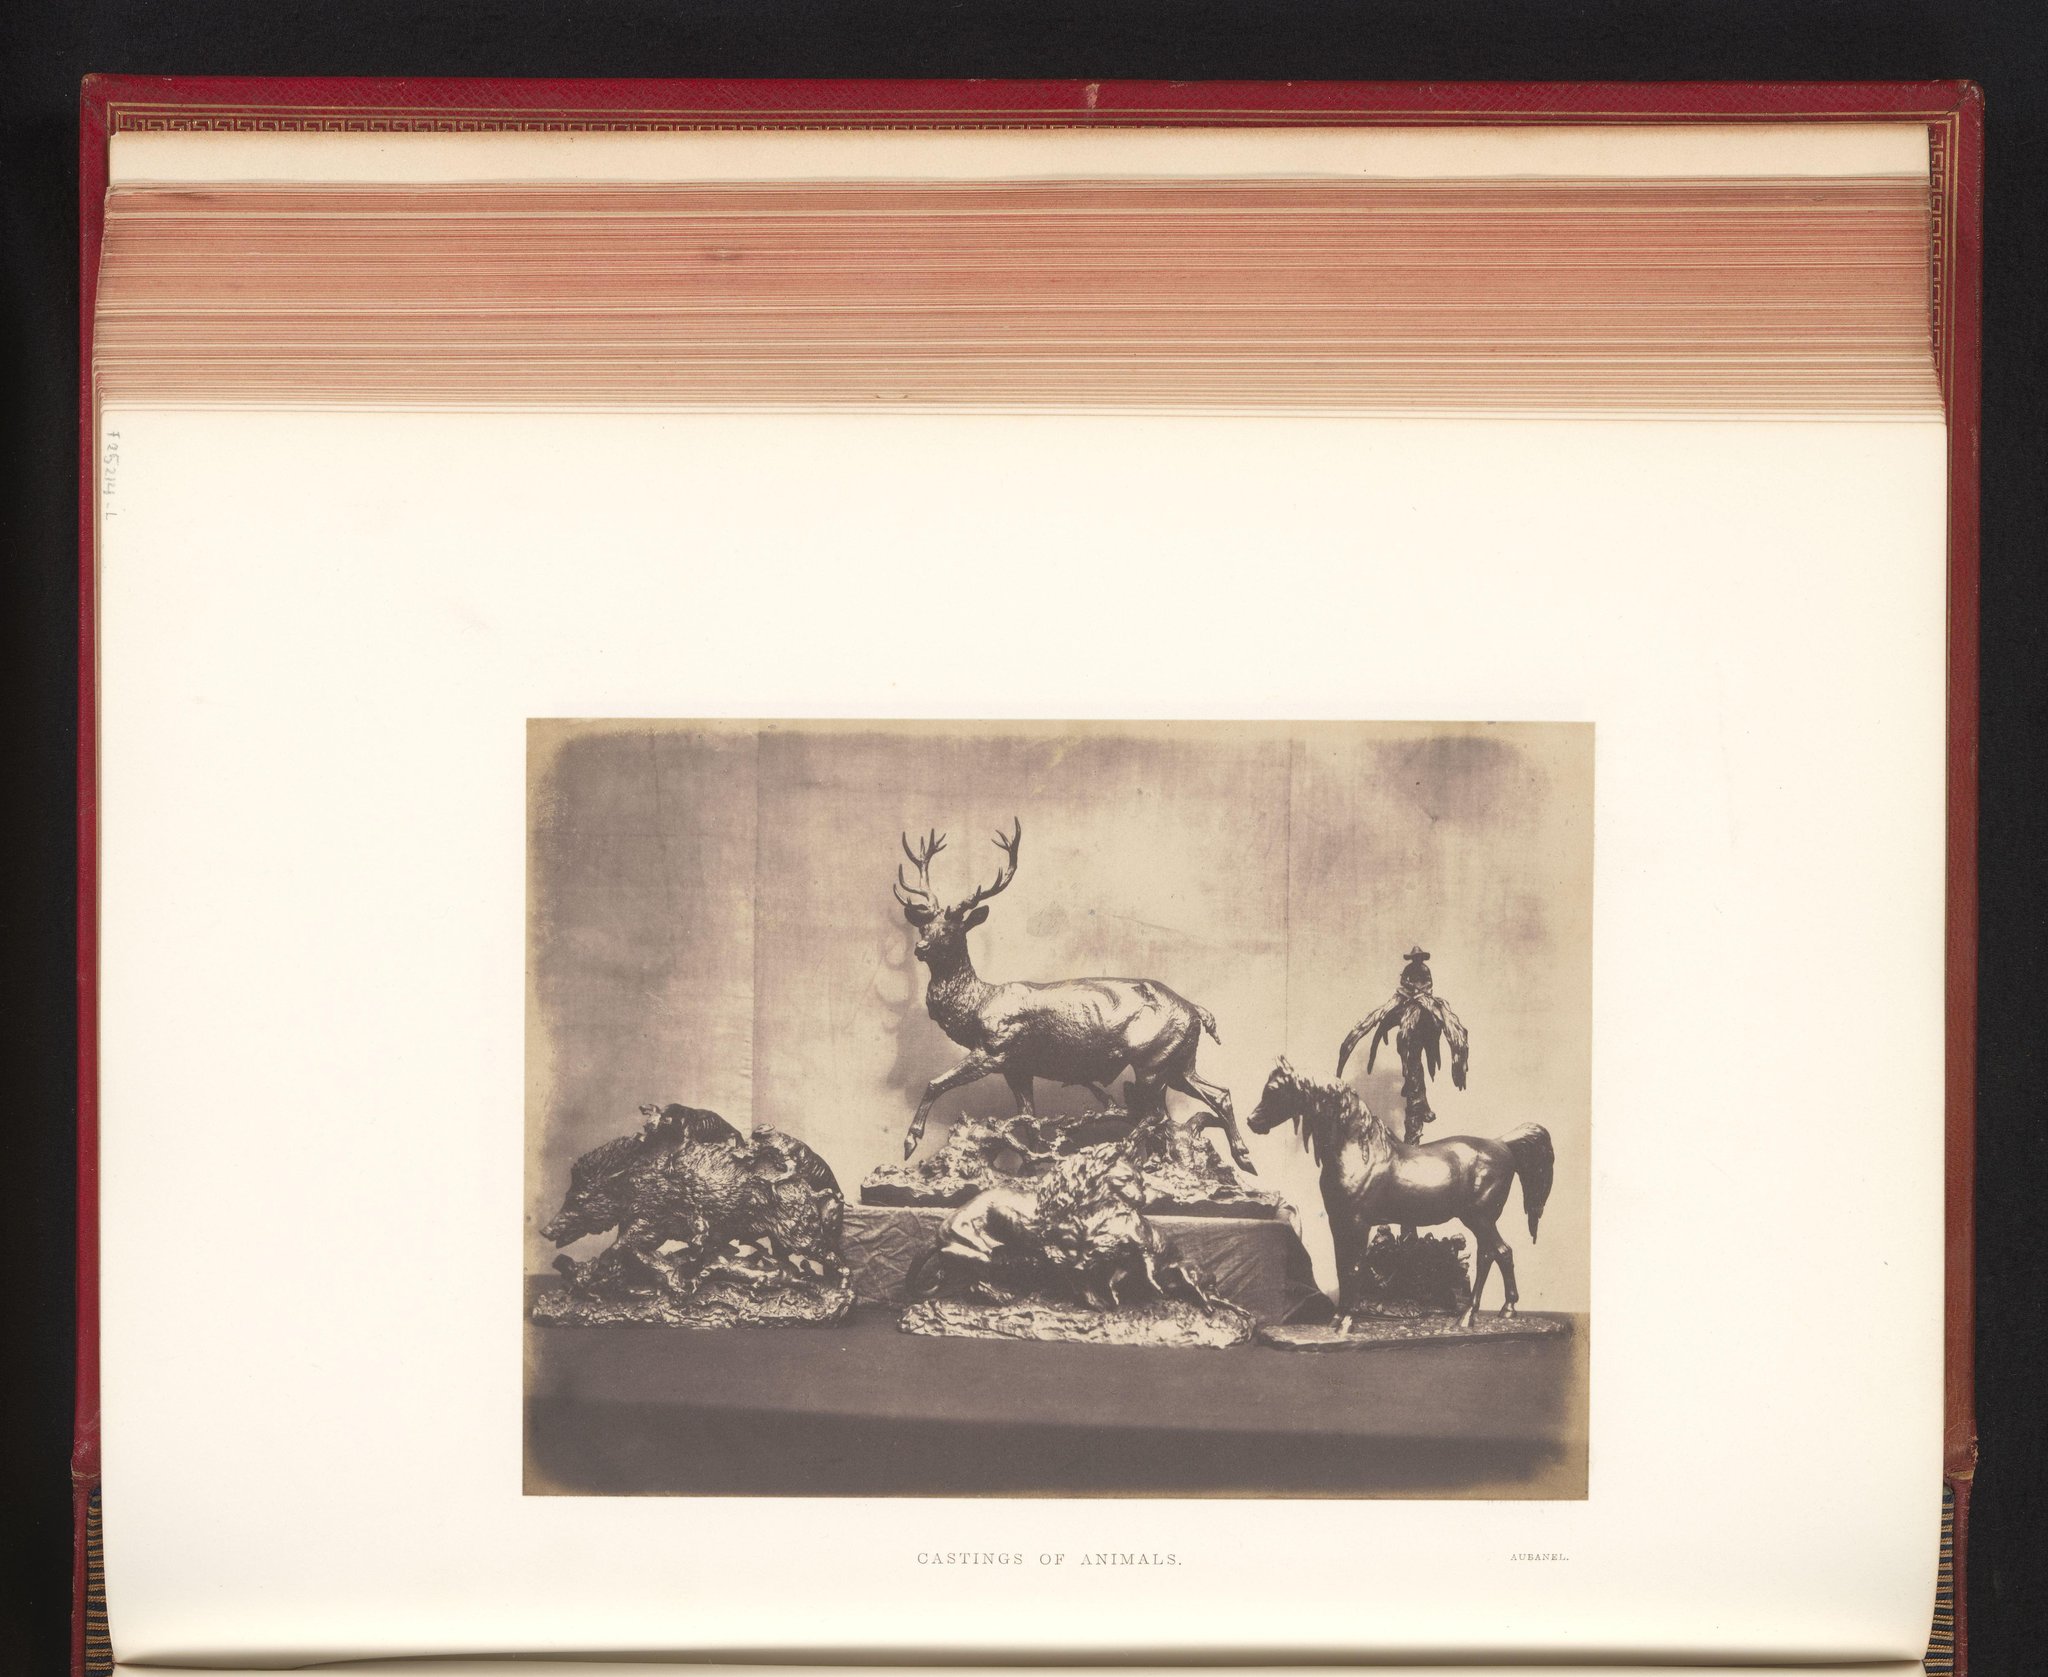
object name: photograph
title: Gietijzeren sculpturen van dieren van Aubanel tentoongesteld op de Great Exhibition of the Works of Industry of All Nations van 1851 in Londen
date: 1851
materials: photographic support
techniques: salted paper print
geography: london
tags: piece of sculpture, reproduction of a piece of sculpture, london